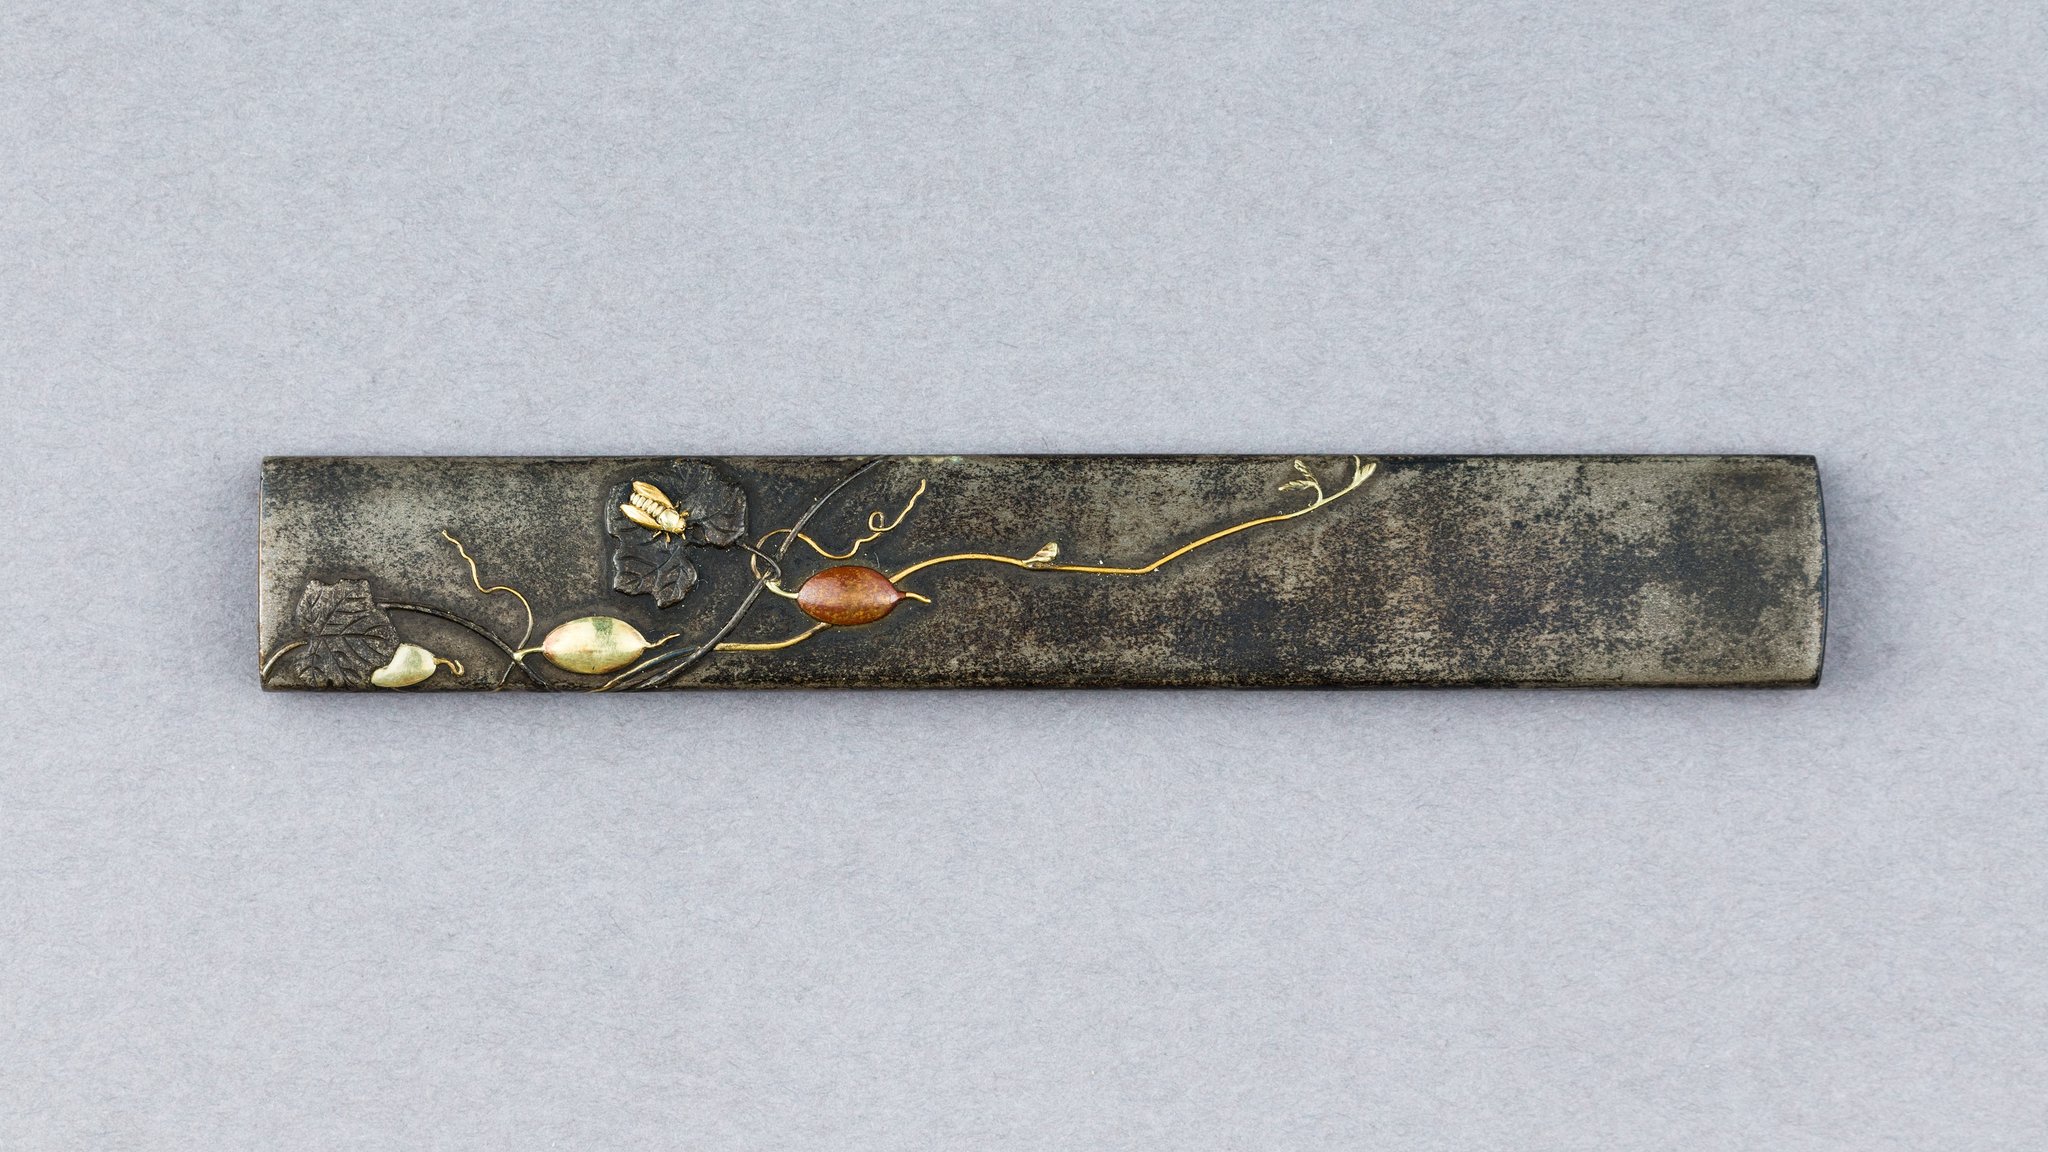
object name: knife handle kozuka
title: Knife Handle (Kozuka)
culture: japanese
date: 1615-1868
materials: copper, silver alloy, gold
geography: japan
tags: plants